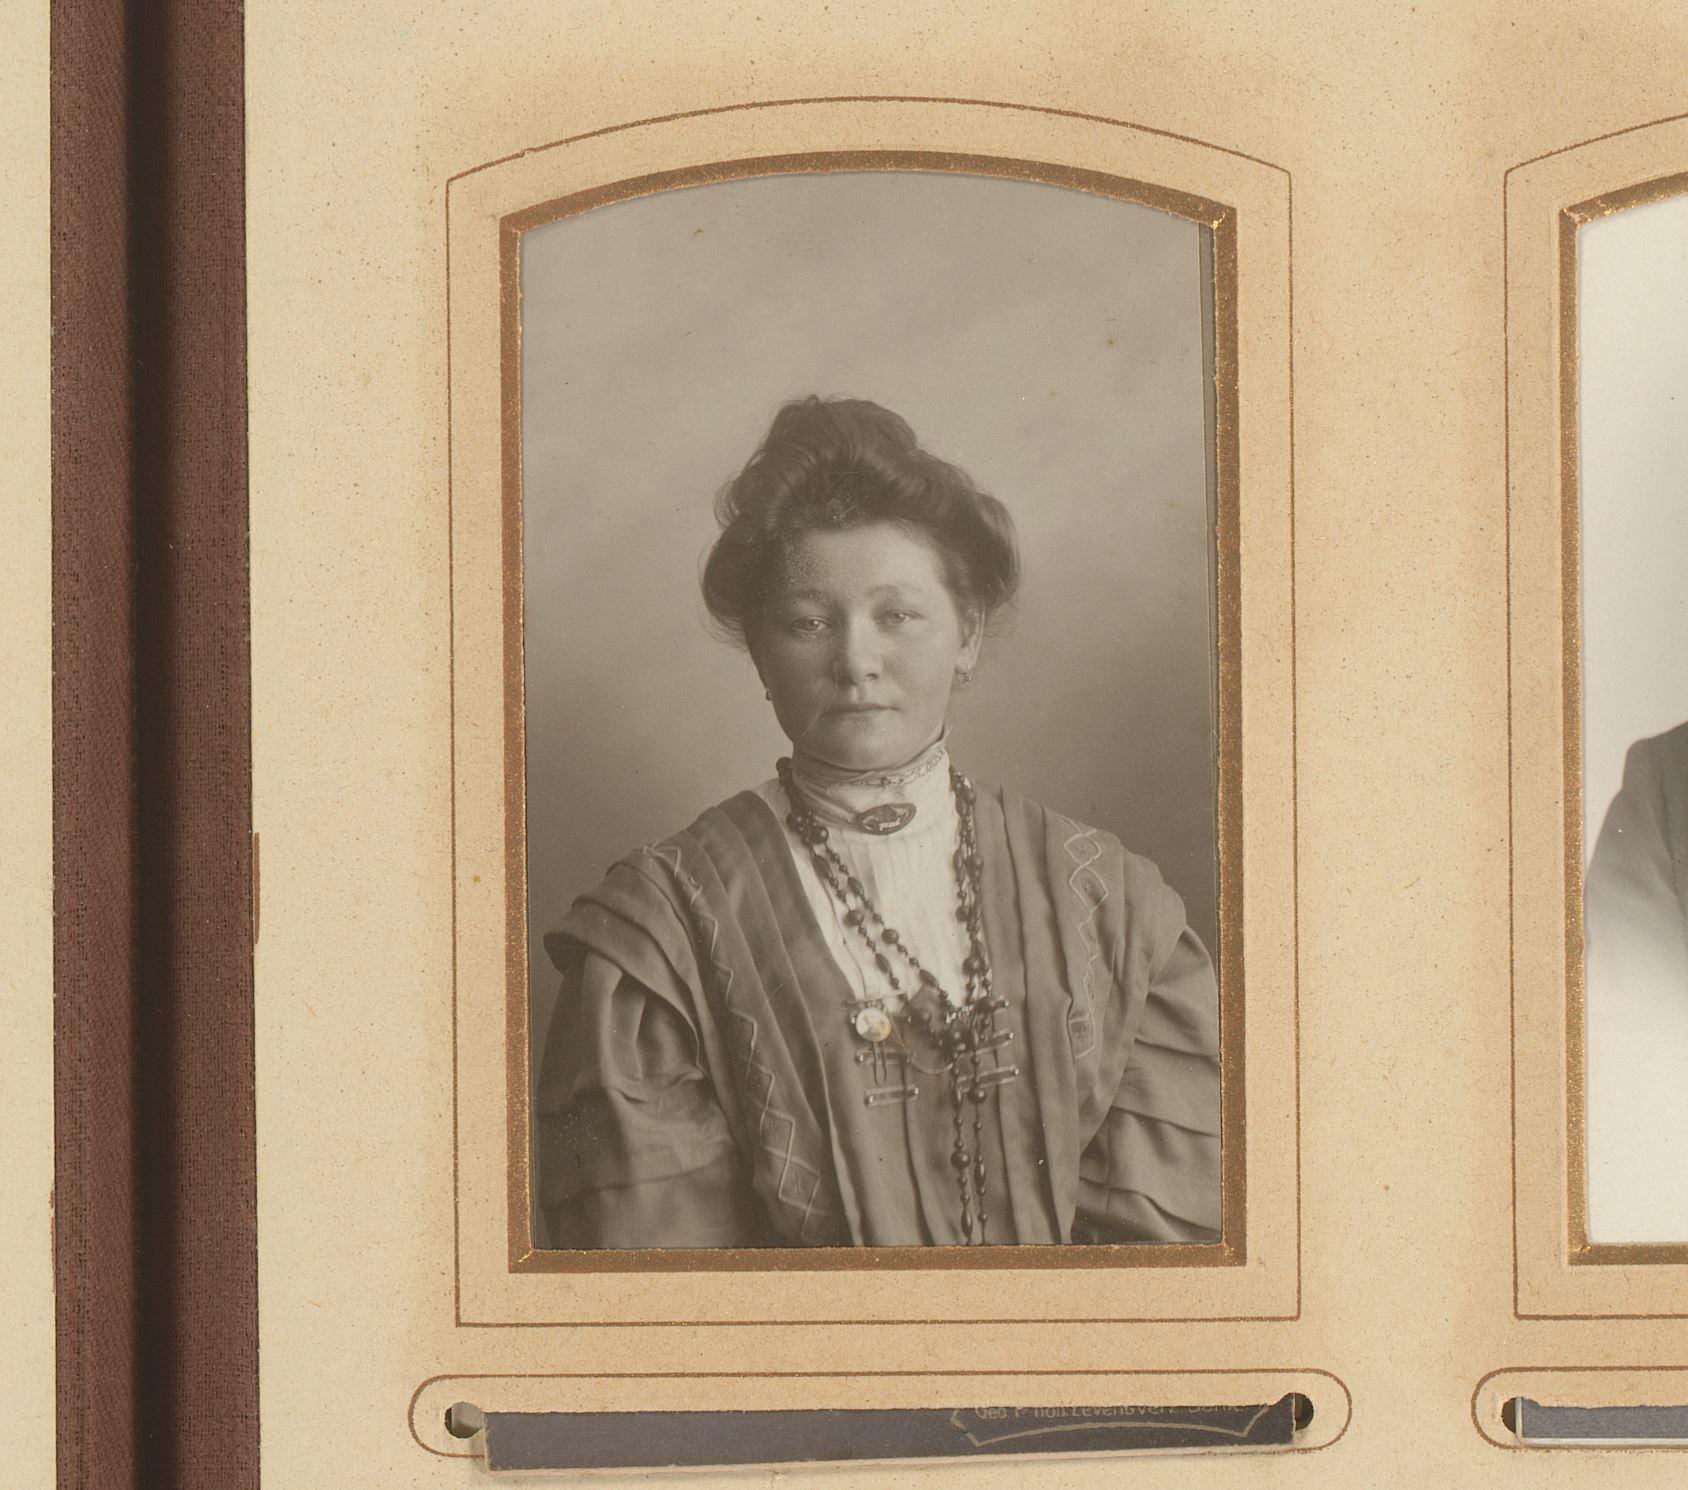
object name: photograph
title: Portret van een vrouw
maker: gerrit leenheer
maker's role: fotograaf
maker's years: 1874-1940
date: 1890-1920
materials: cardboard, photographic support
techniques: collodion silver print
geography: amsterdam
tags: historical persons - bb - woman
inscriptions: inscription: ‘G. Leenheer/ Vijzelgracht 27/ Geb 1e Holl. Levensverz. Bank’